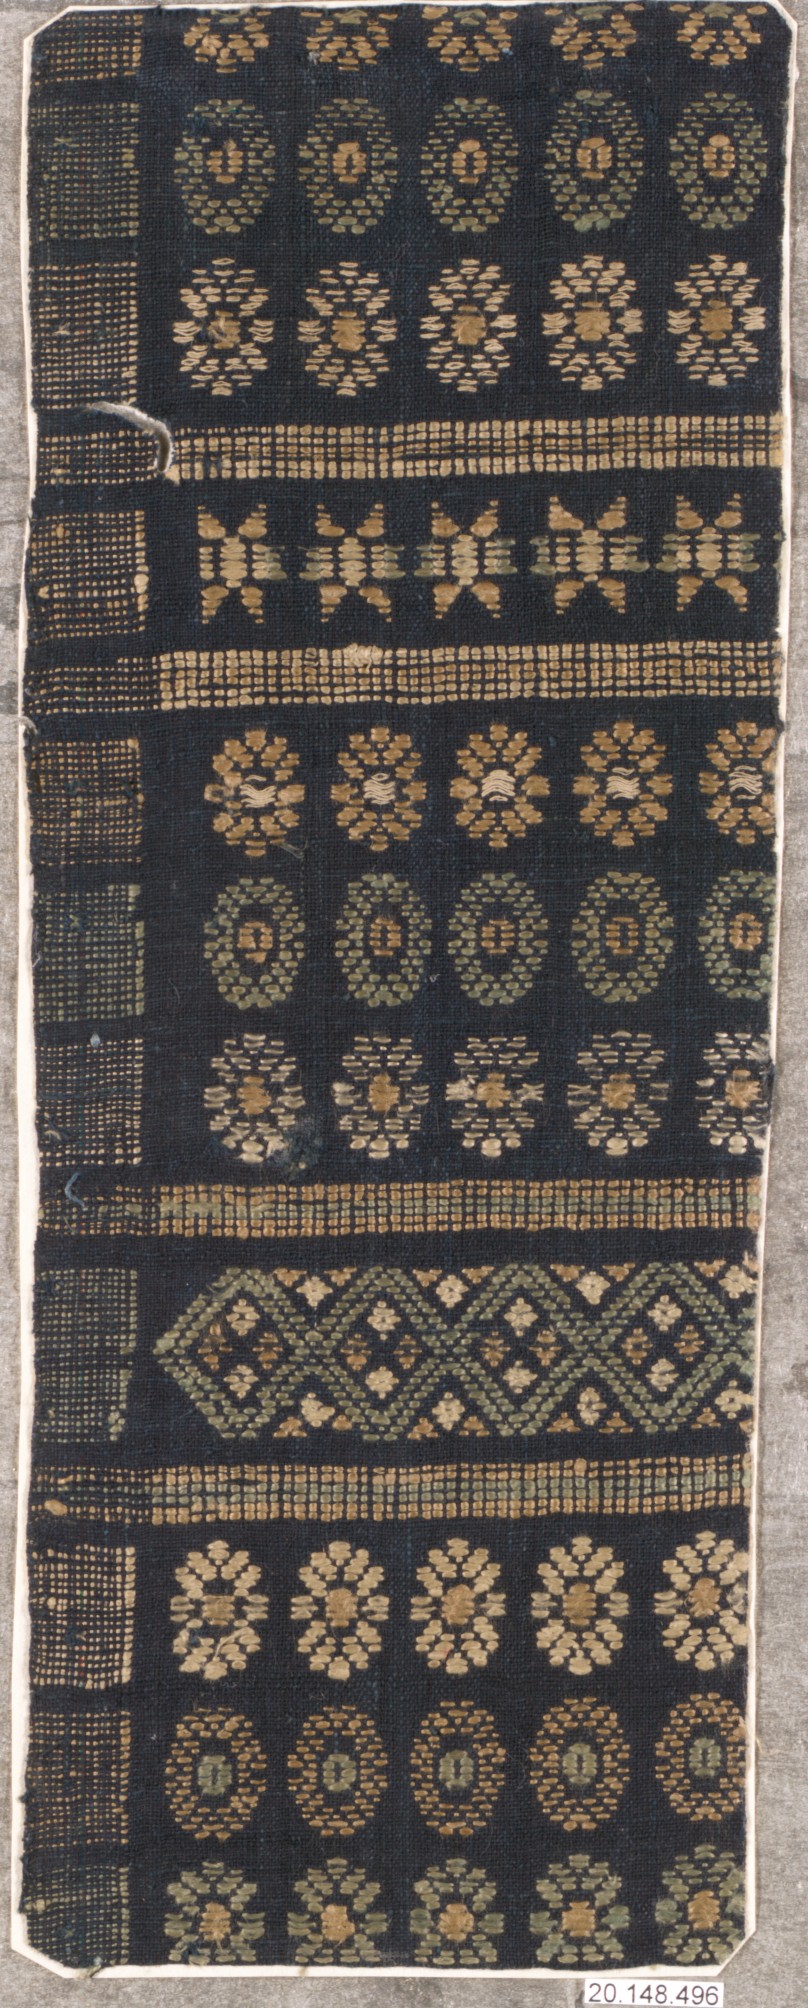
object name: piece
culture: chinese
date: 1701-1800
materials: silk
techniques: compound weave